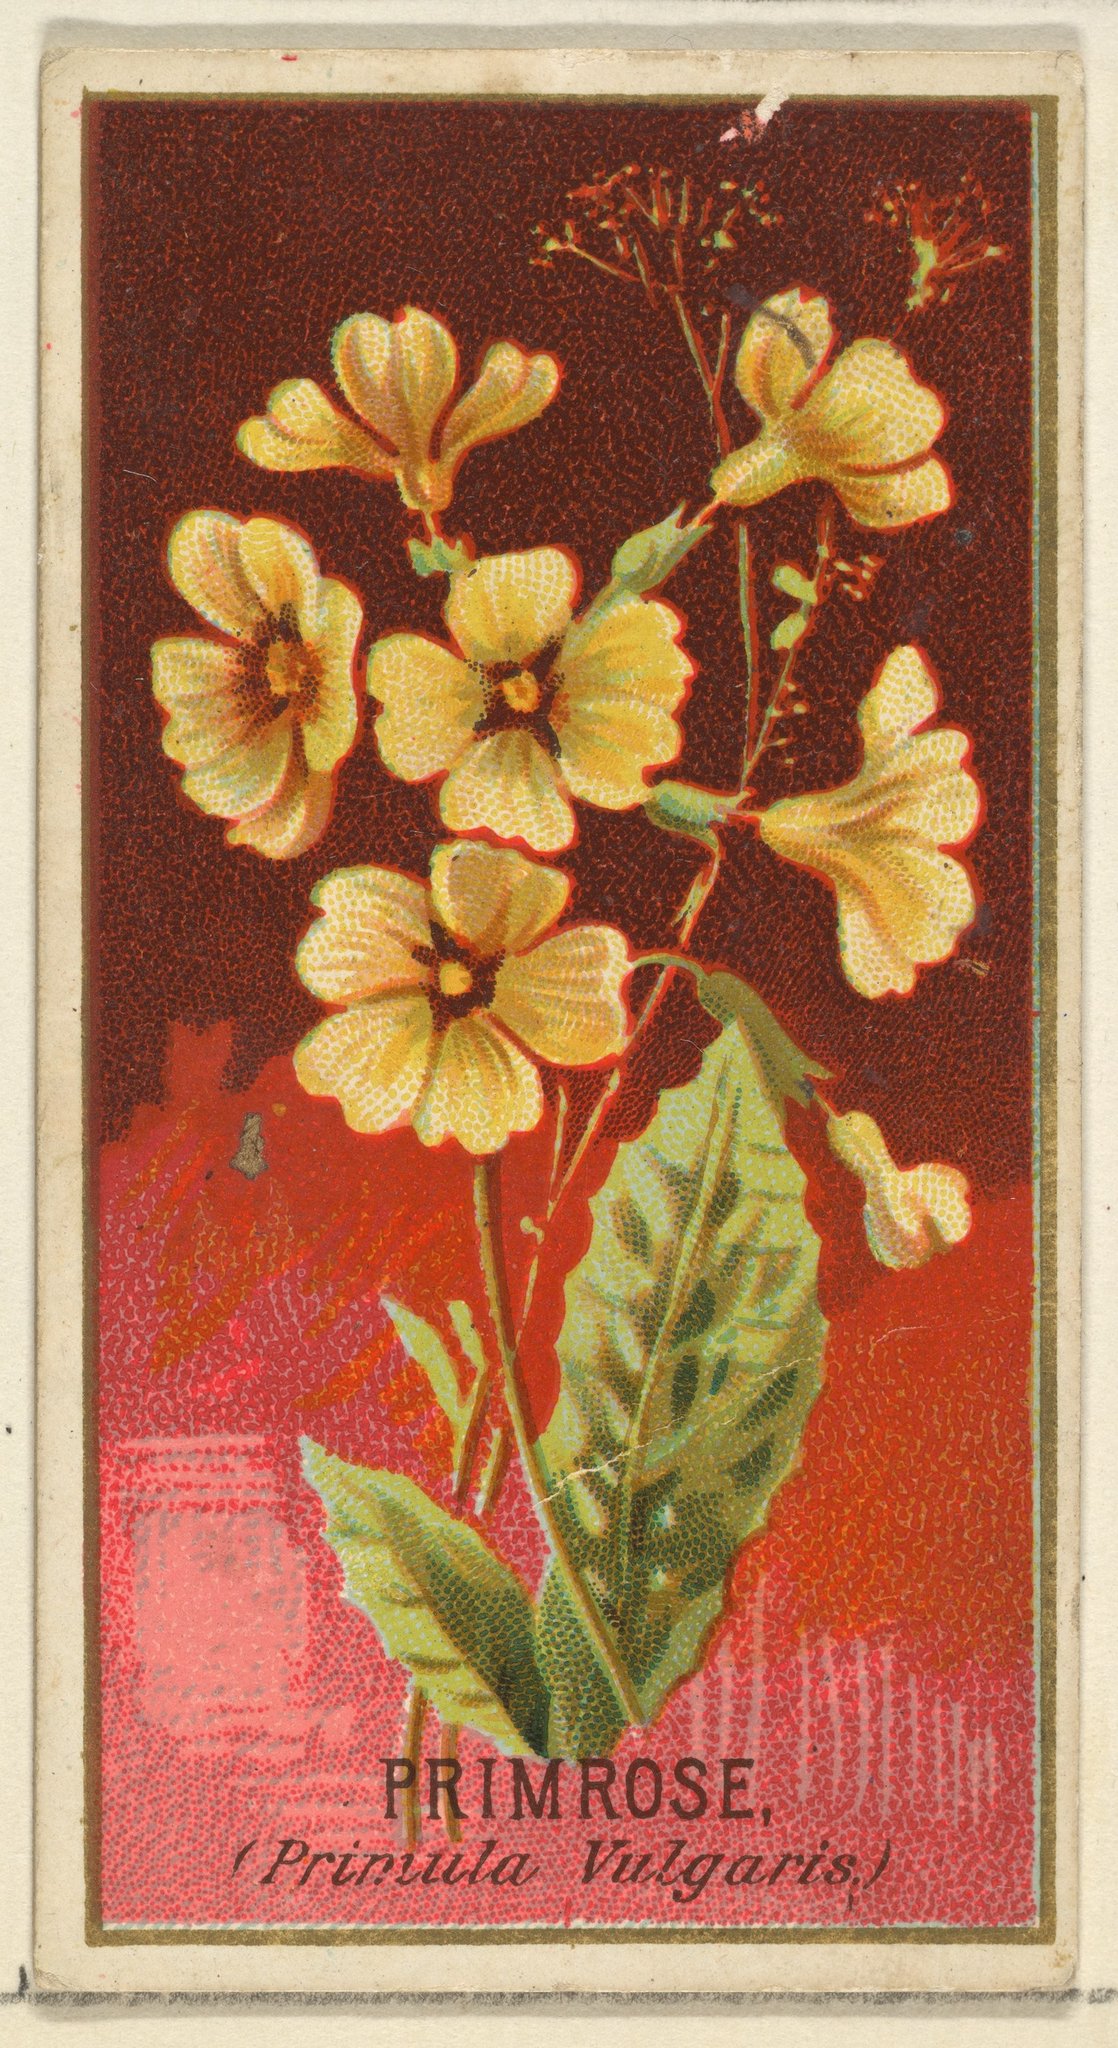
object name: print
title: Primrose (Primula Vulgaris), from the Flowers series for Old Judge Cigarettes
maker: goodwin & company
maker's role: publisher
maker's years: 1850-1950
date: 1890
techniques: color lithograph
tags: flowers,leaves